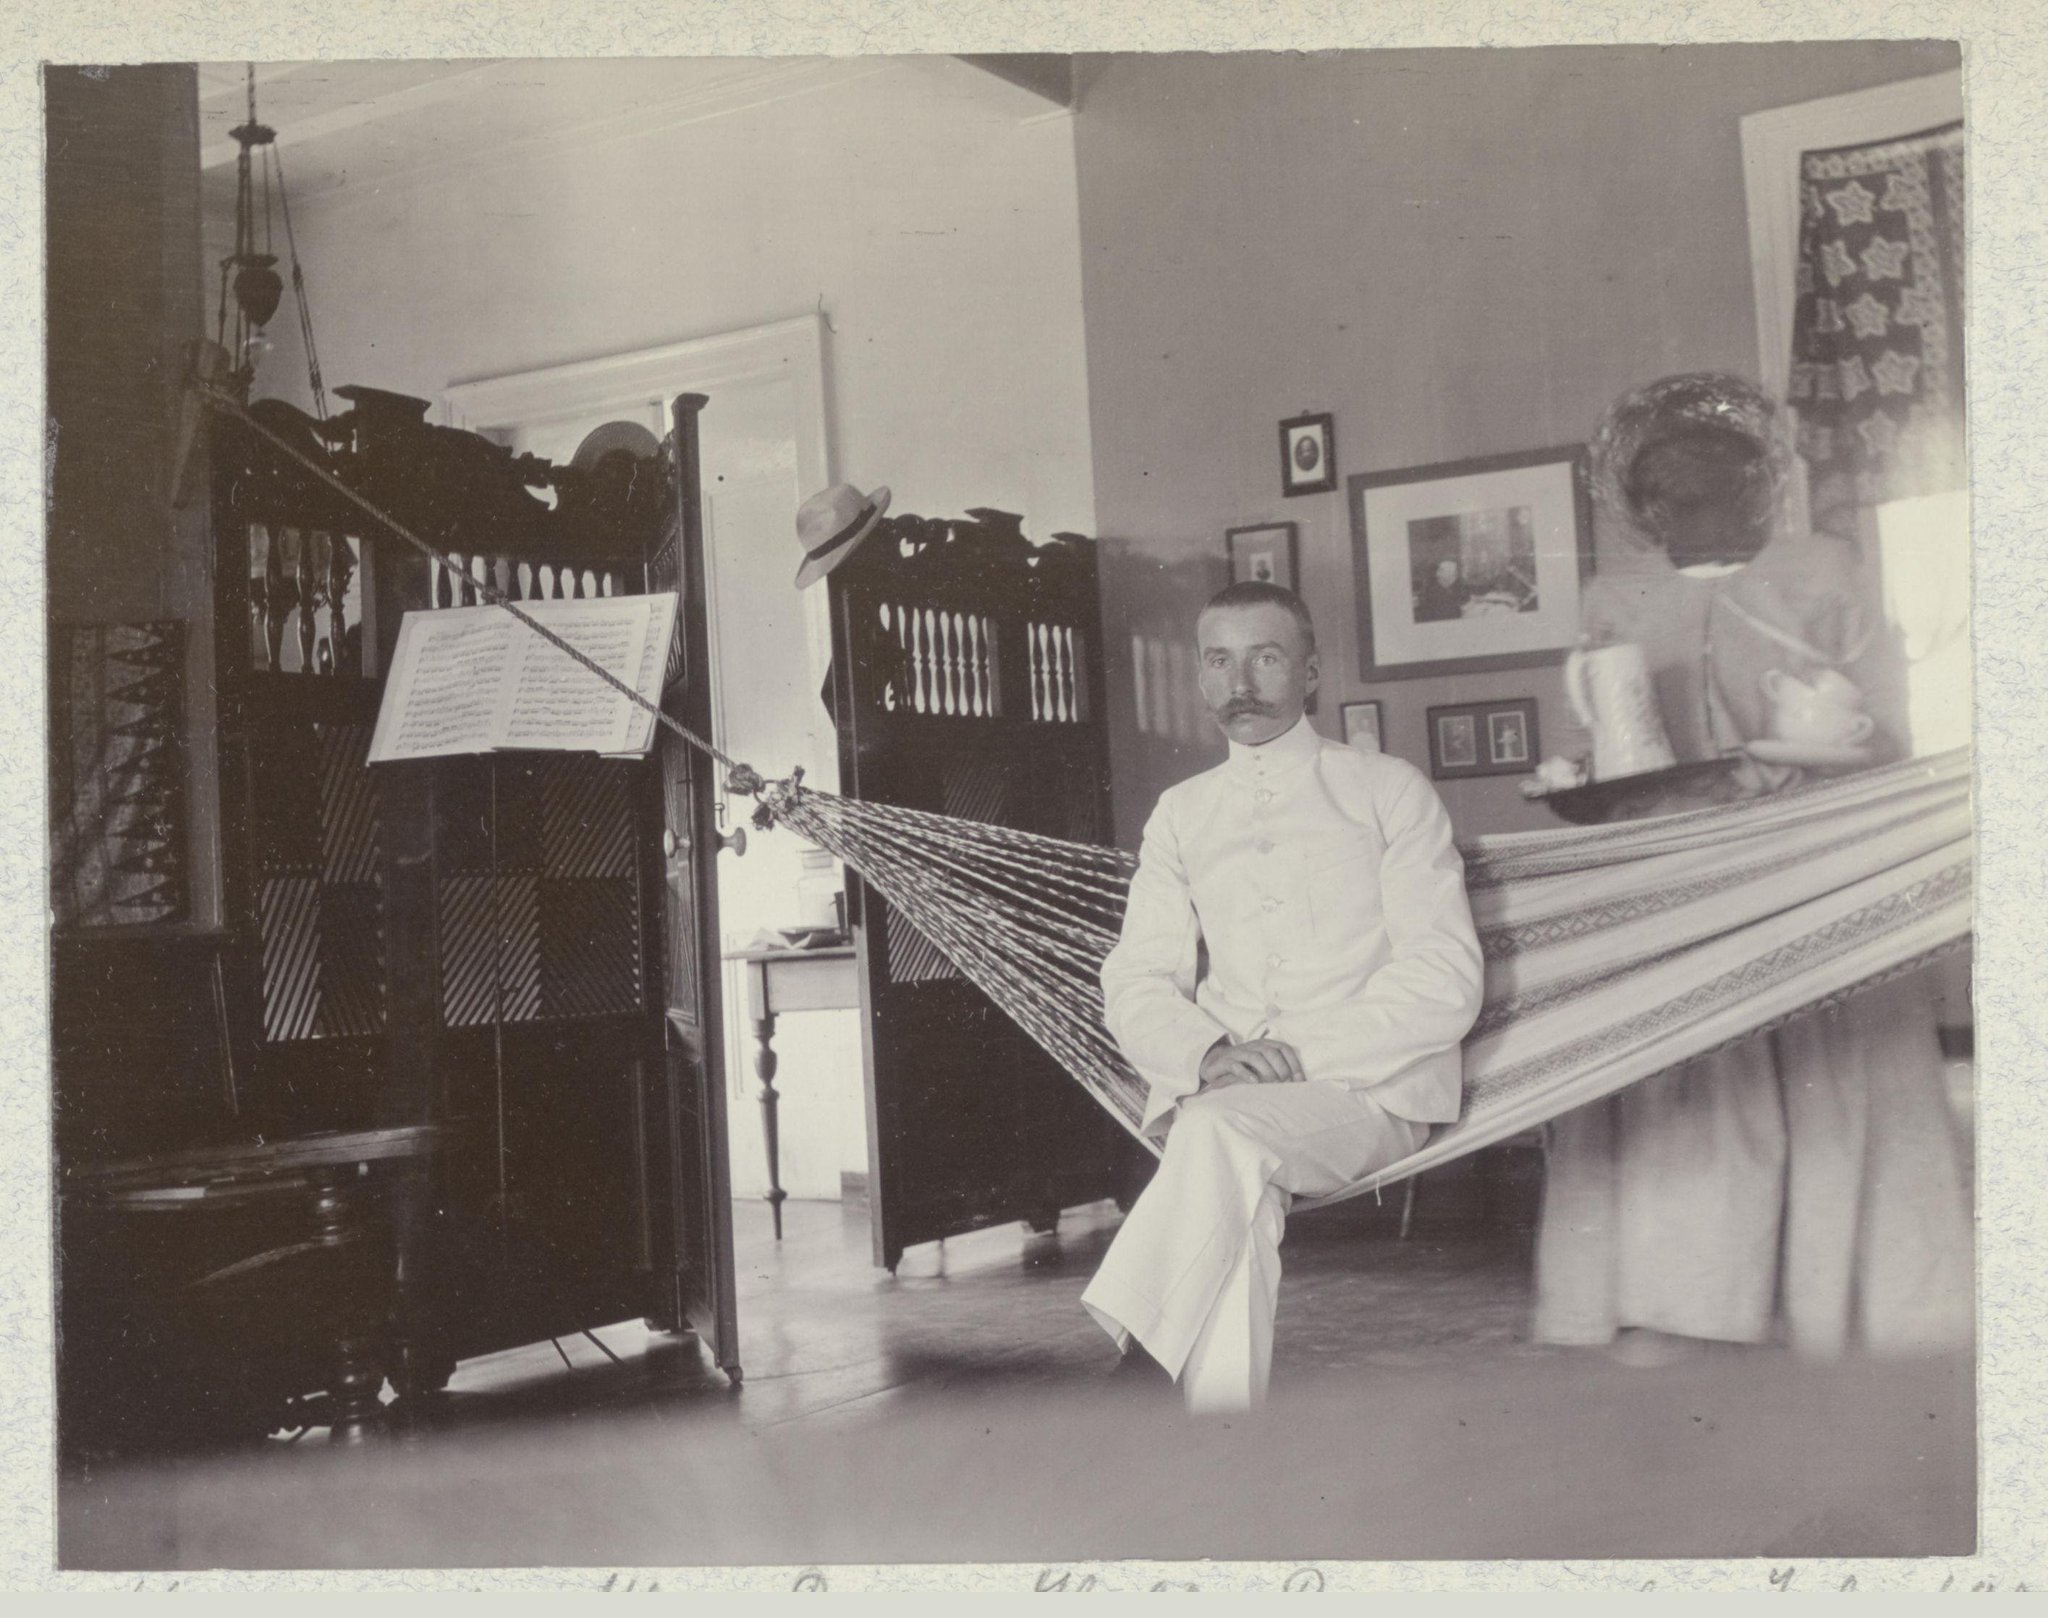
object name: photograph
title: Hangmat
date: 1908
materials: photographic support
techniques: photography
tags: andries augustus boom, hammock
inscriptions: inscription: ‘Huis van den Heer Dr van Hall. Paramaribo Juli 1908’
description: Andries Boom zittend in een hangmat in het huis van Dr. Van Hall in Paramaribo, juli 1908. Onderdeel van het fotoalbum van de familie Boom-Gonggrijp in Suriname en Curaçao.